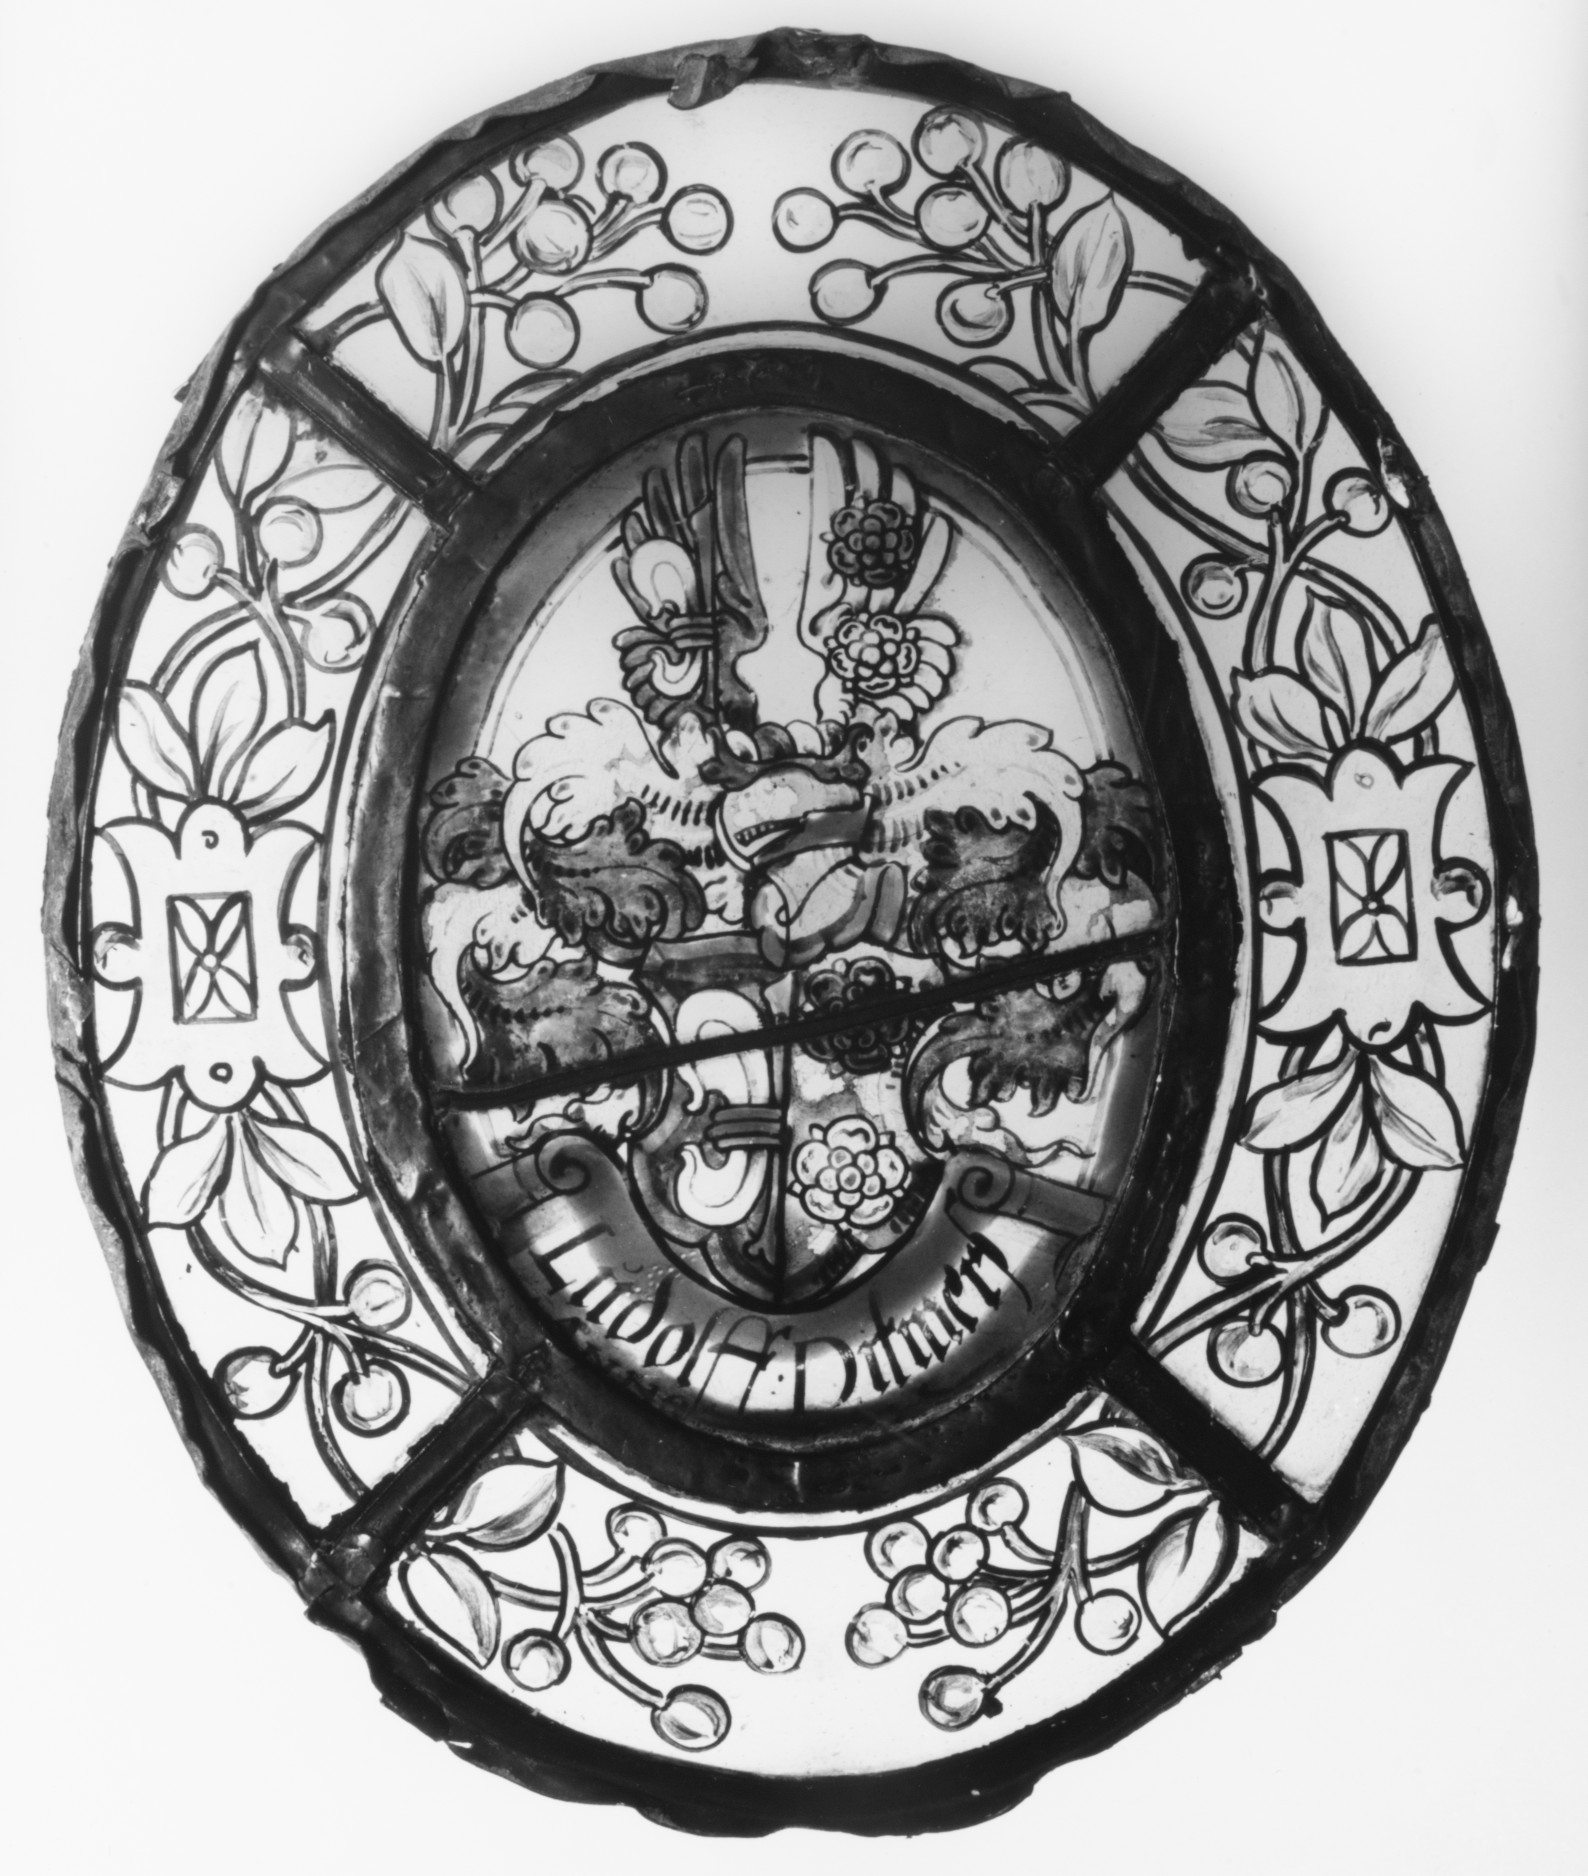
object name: armorial panel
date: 1617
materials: glass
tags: coat of arms